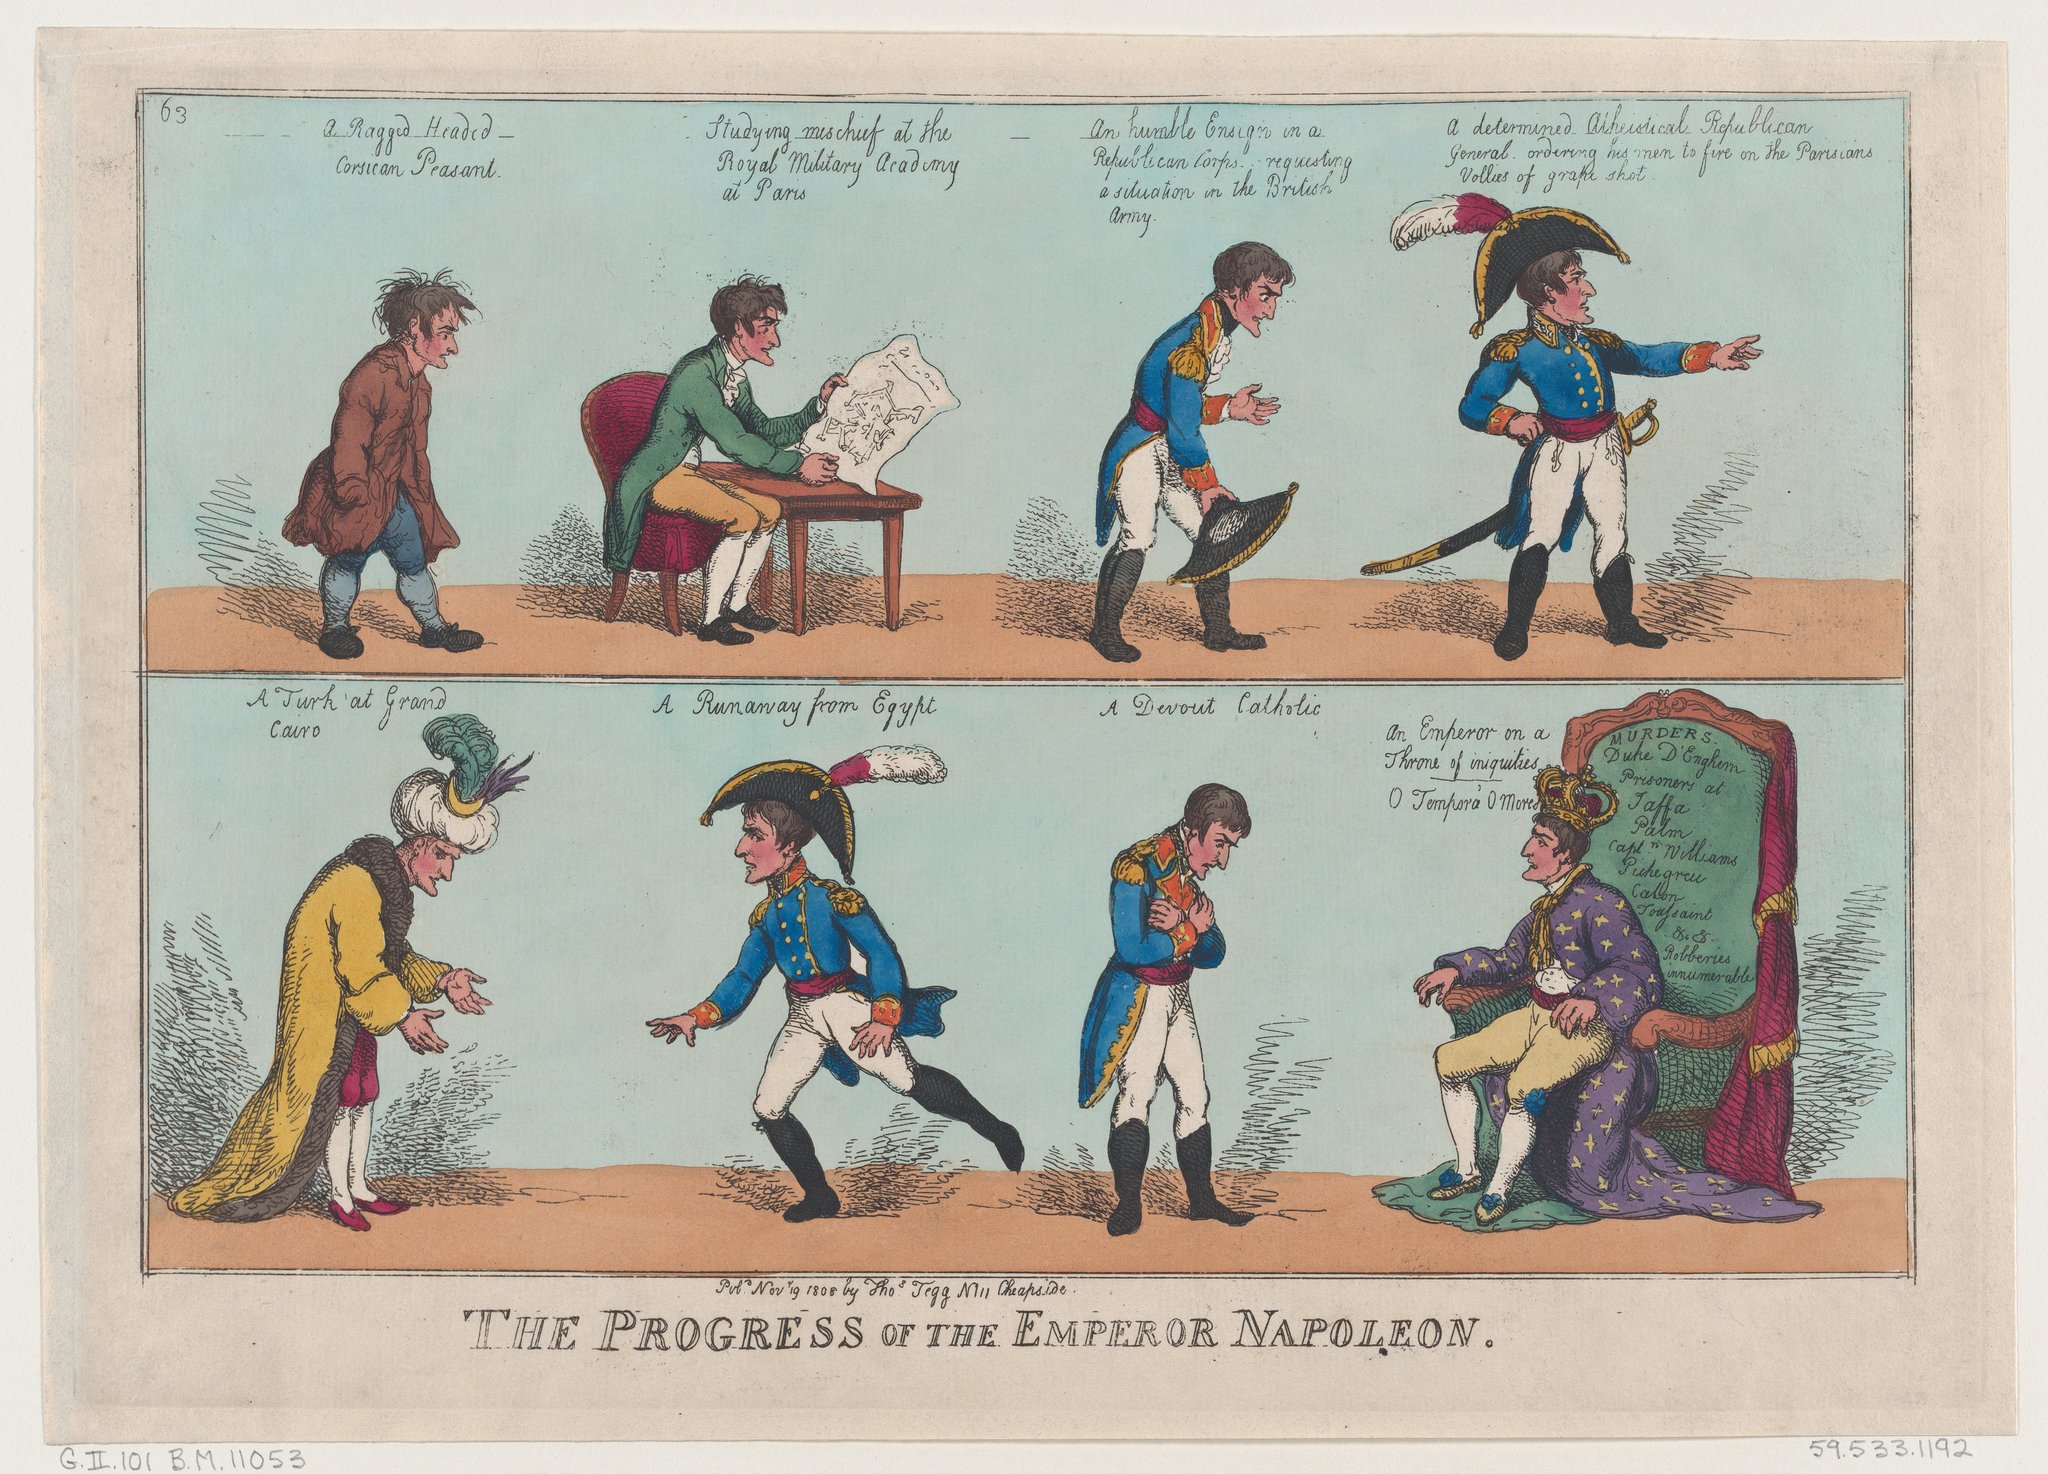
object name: print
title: The Progress of the Emperor Napoleon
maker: thomas rowlandson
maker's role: artist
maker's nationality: british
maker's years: 1757-1827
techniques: etching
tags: satire,napoleon i,men,politics